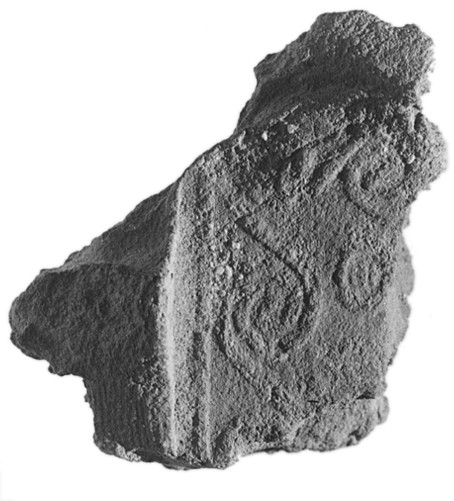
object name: sealing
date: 2030-1640 BCE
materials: clay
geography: egypt